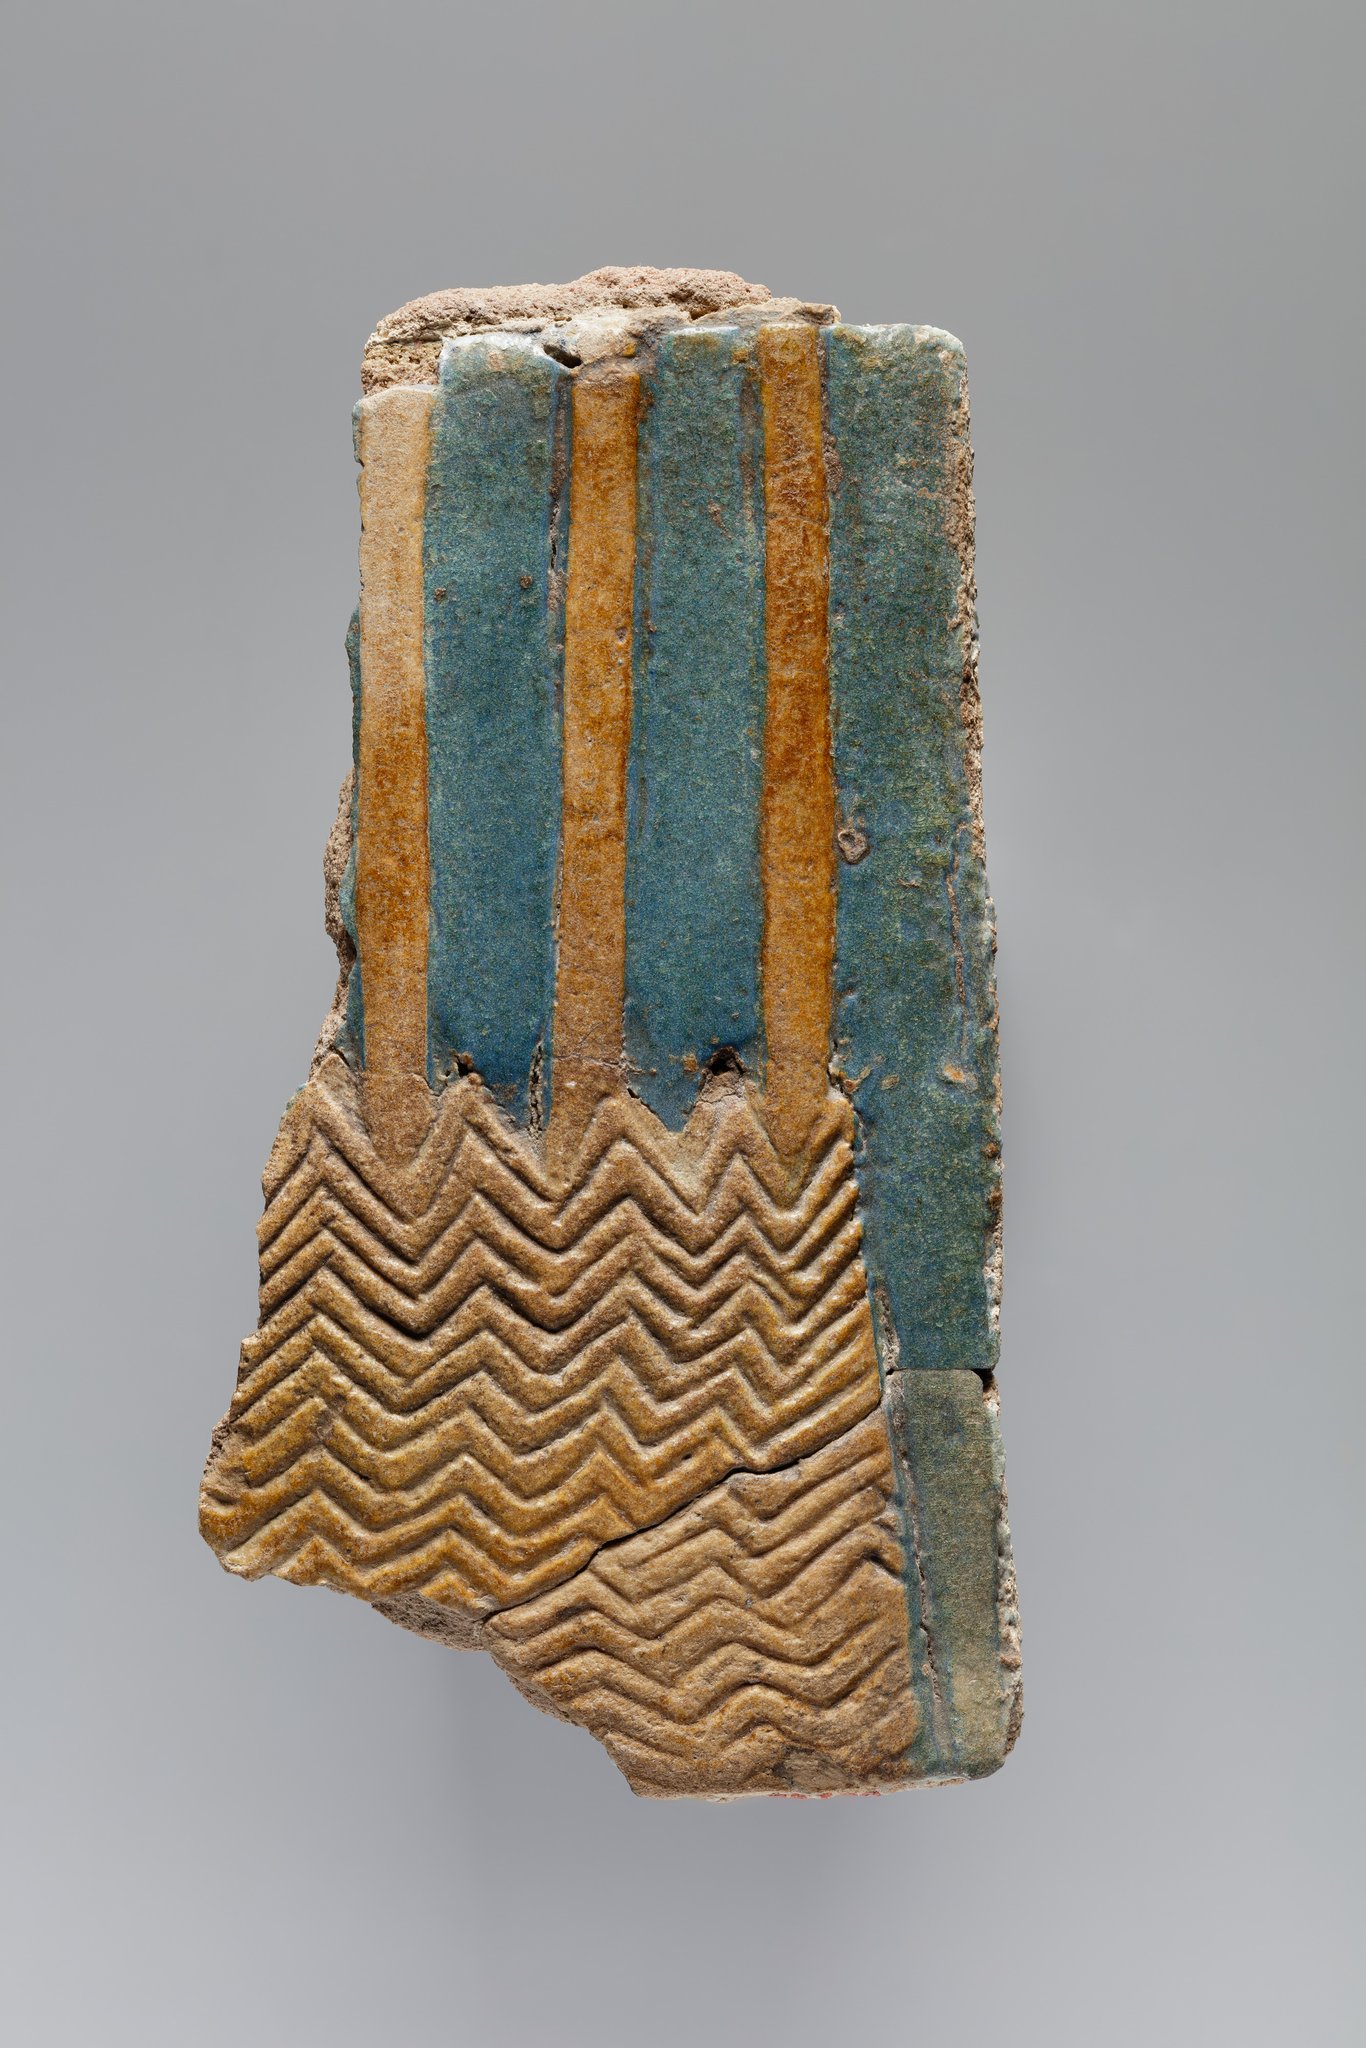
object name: tile, palace of ramesses ii, marsh scene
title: Tile fragment of clumps of sedge and papyrus plants from the palace of Ramesses II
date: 1279-1213 BCE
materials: faience, mortar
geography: egypt